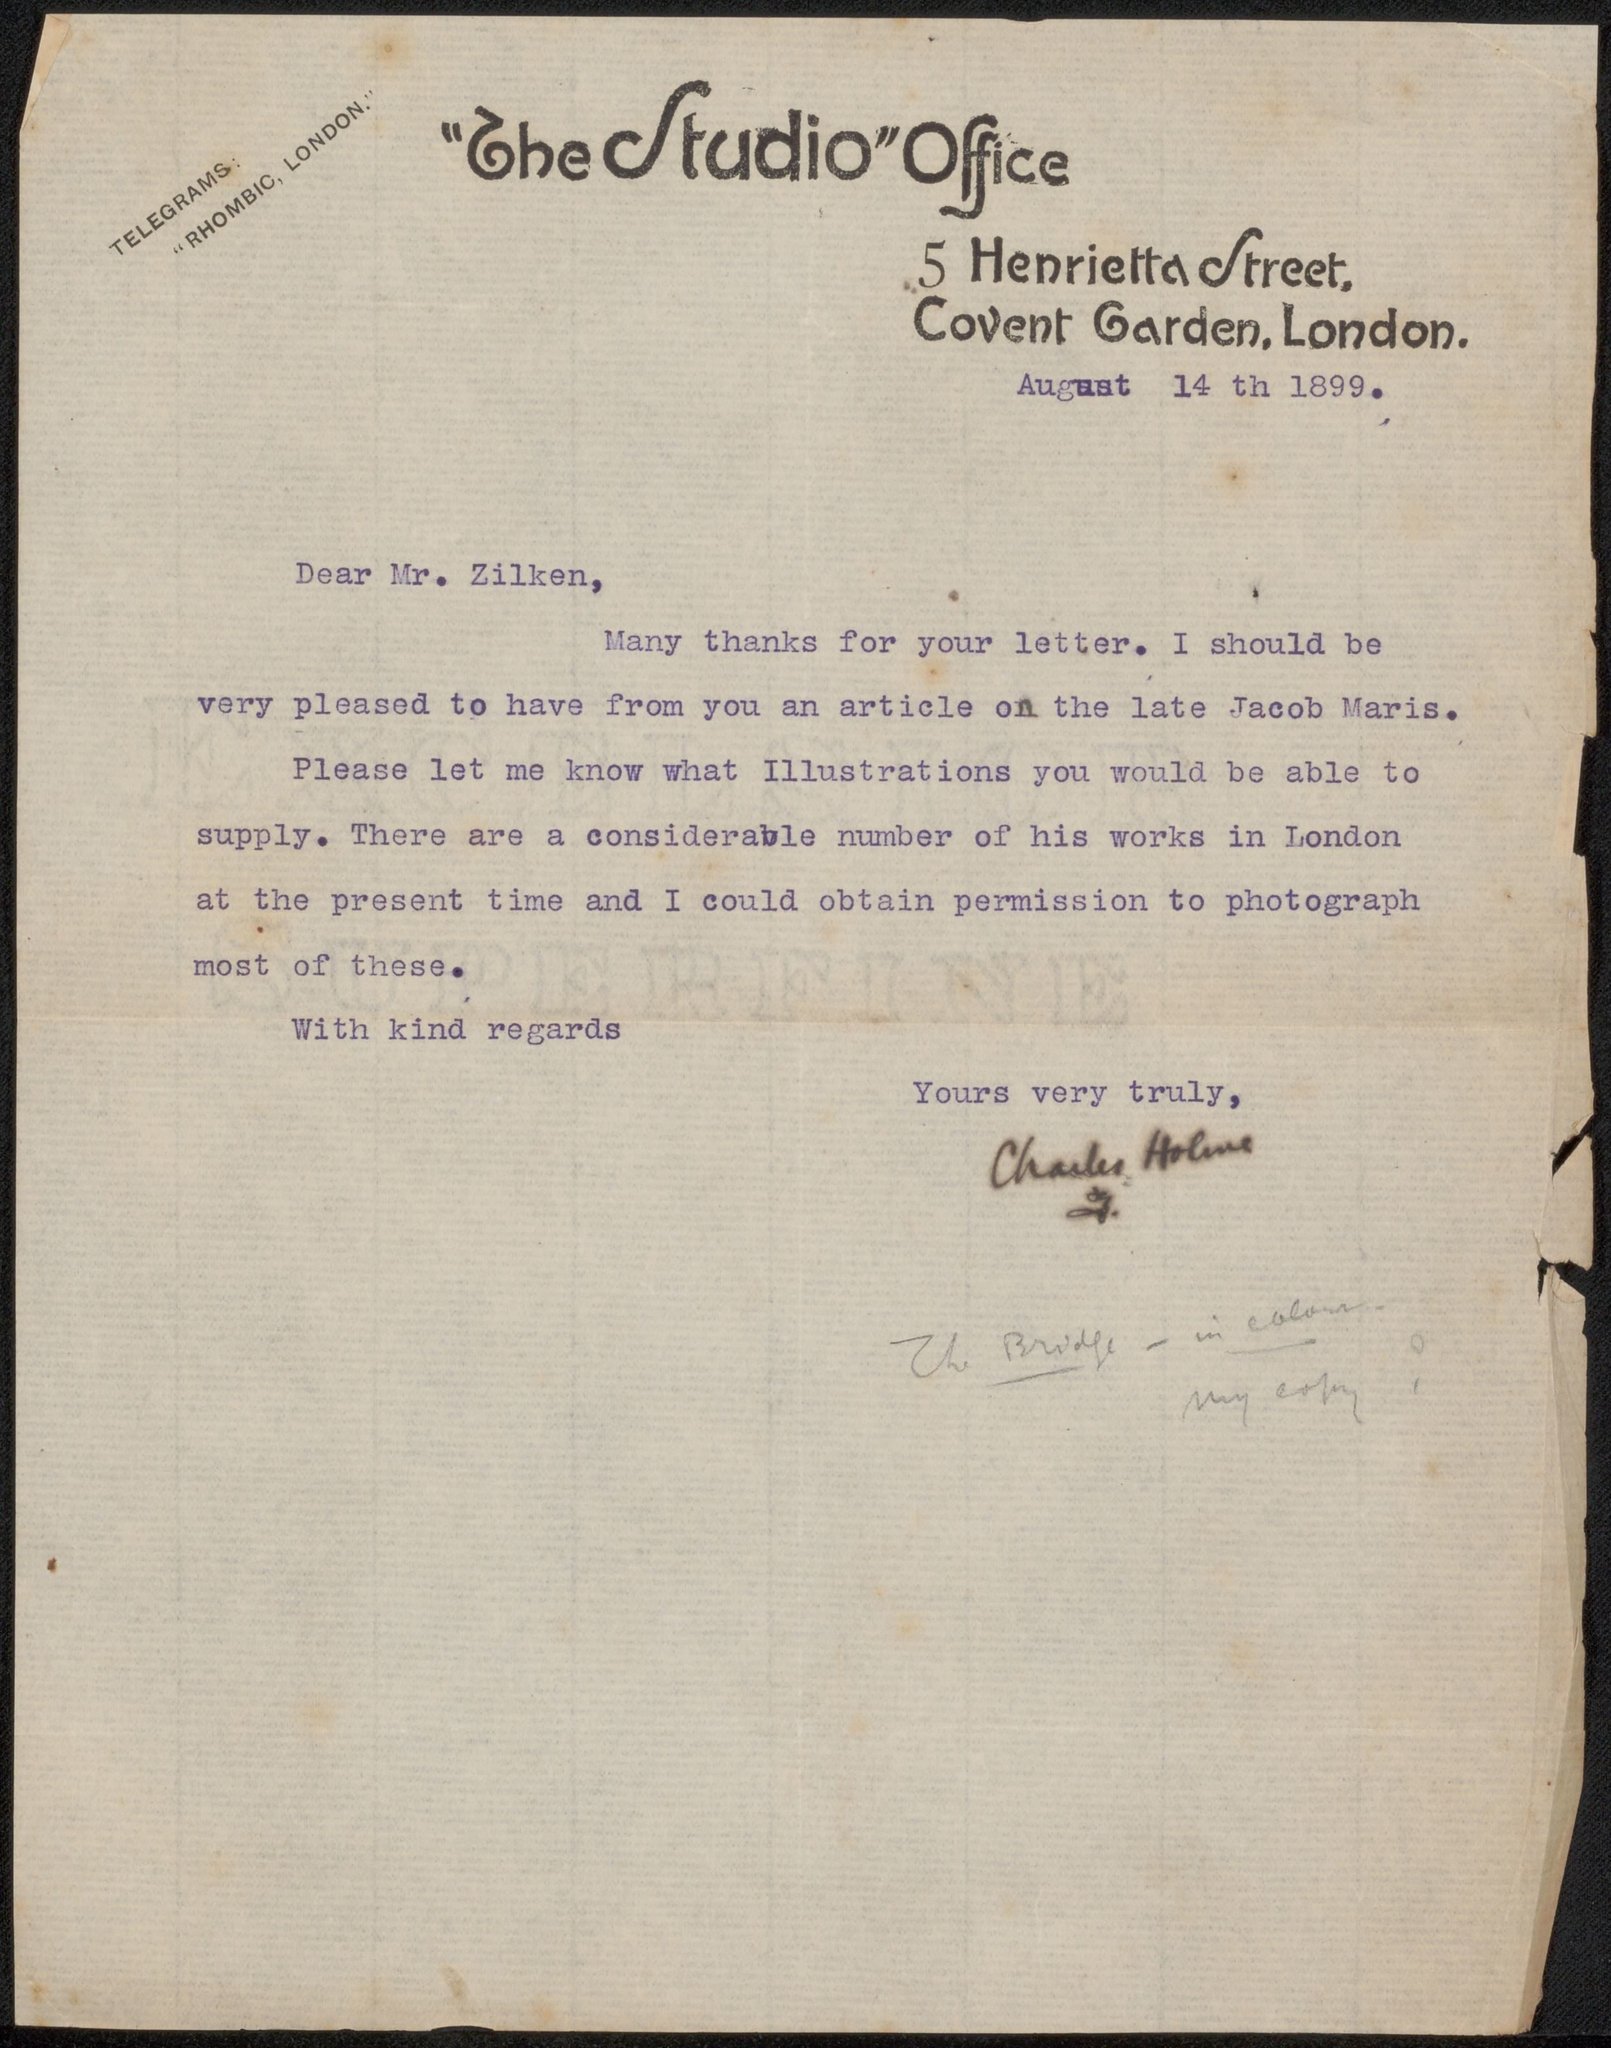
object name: letter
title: Brief aan Philip Zilcken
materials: ink, paper, pencil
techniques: pen, printing, typewriting, writing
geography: london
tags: jacob maris, painter, draughtsman, philip zilcken, photography, cinematography, illustration ~ printed matter, book, printed matter, london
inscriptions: watermark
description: Brief bevat aantekening van Philip Zilcken.